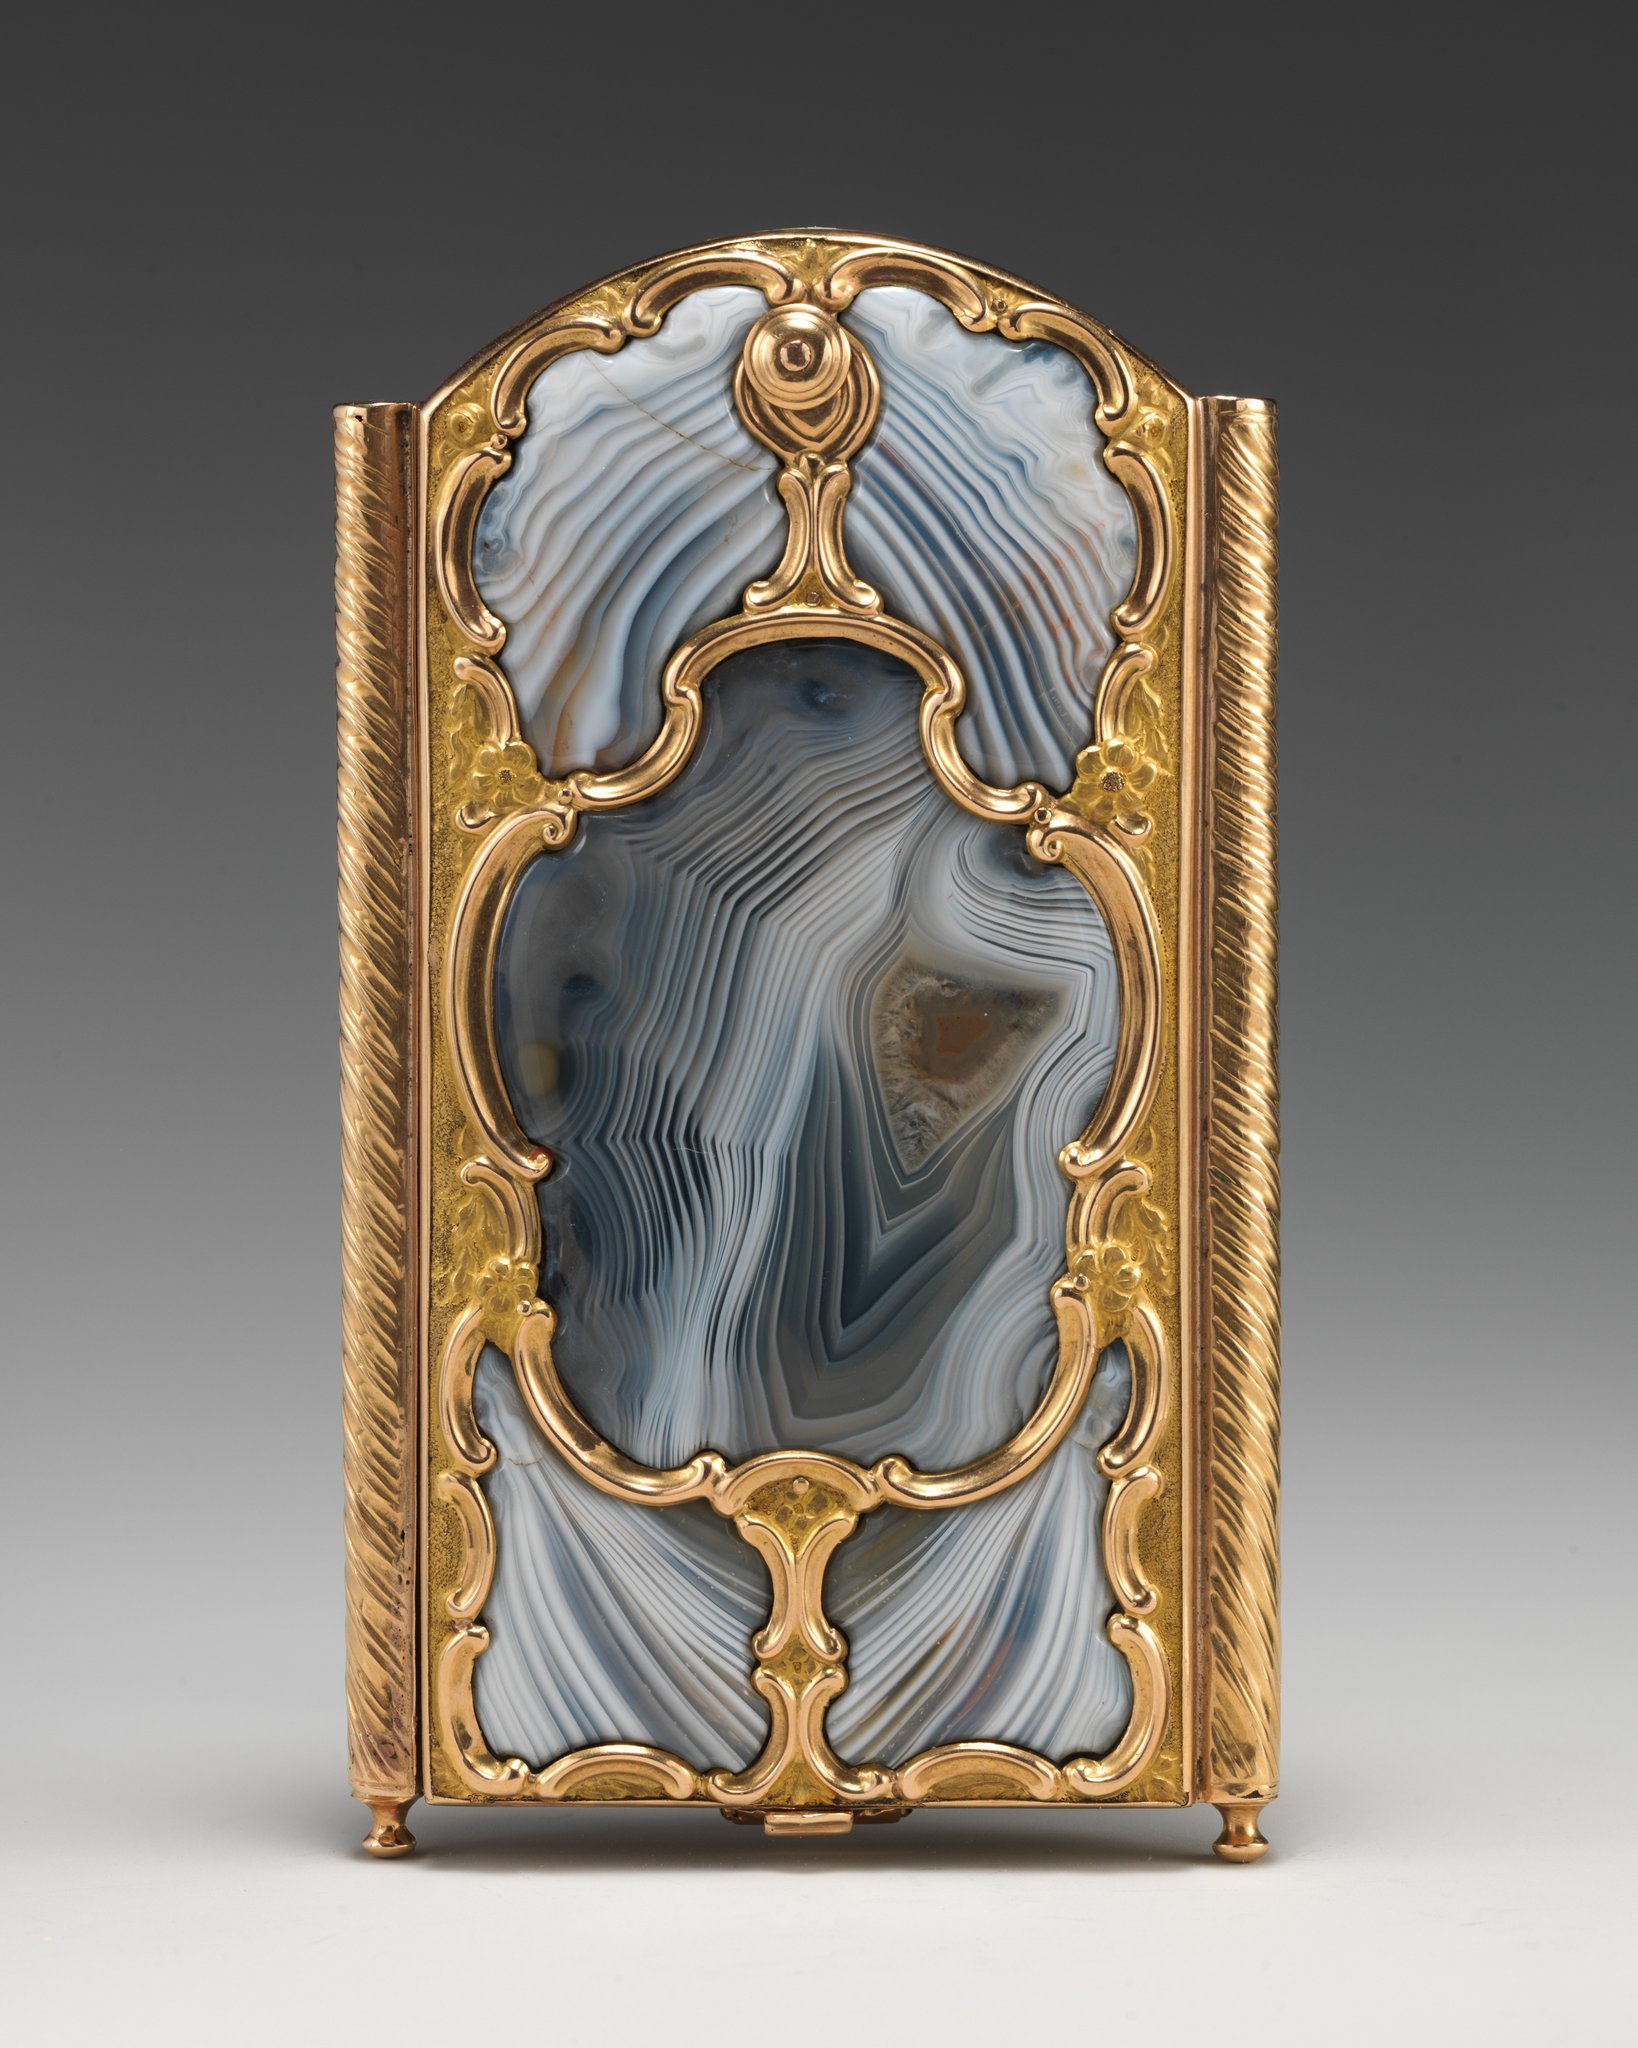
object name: étui porte tablettes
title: Étui porte-tablettes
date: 1701-1800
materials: stone, gold, ivory